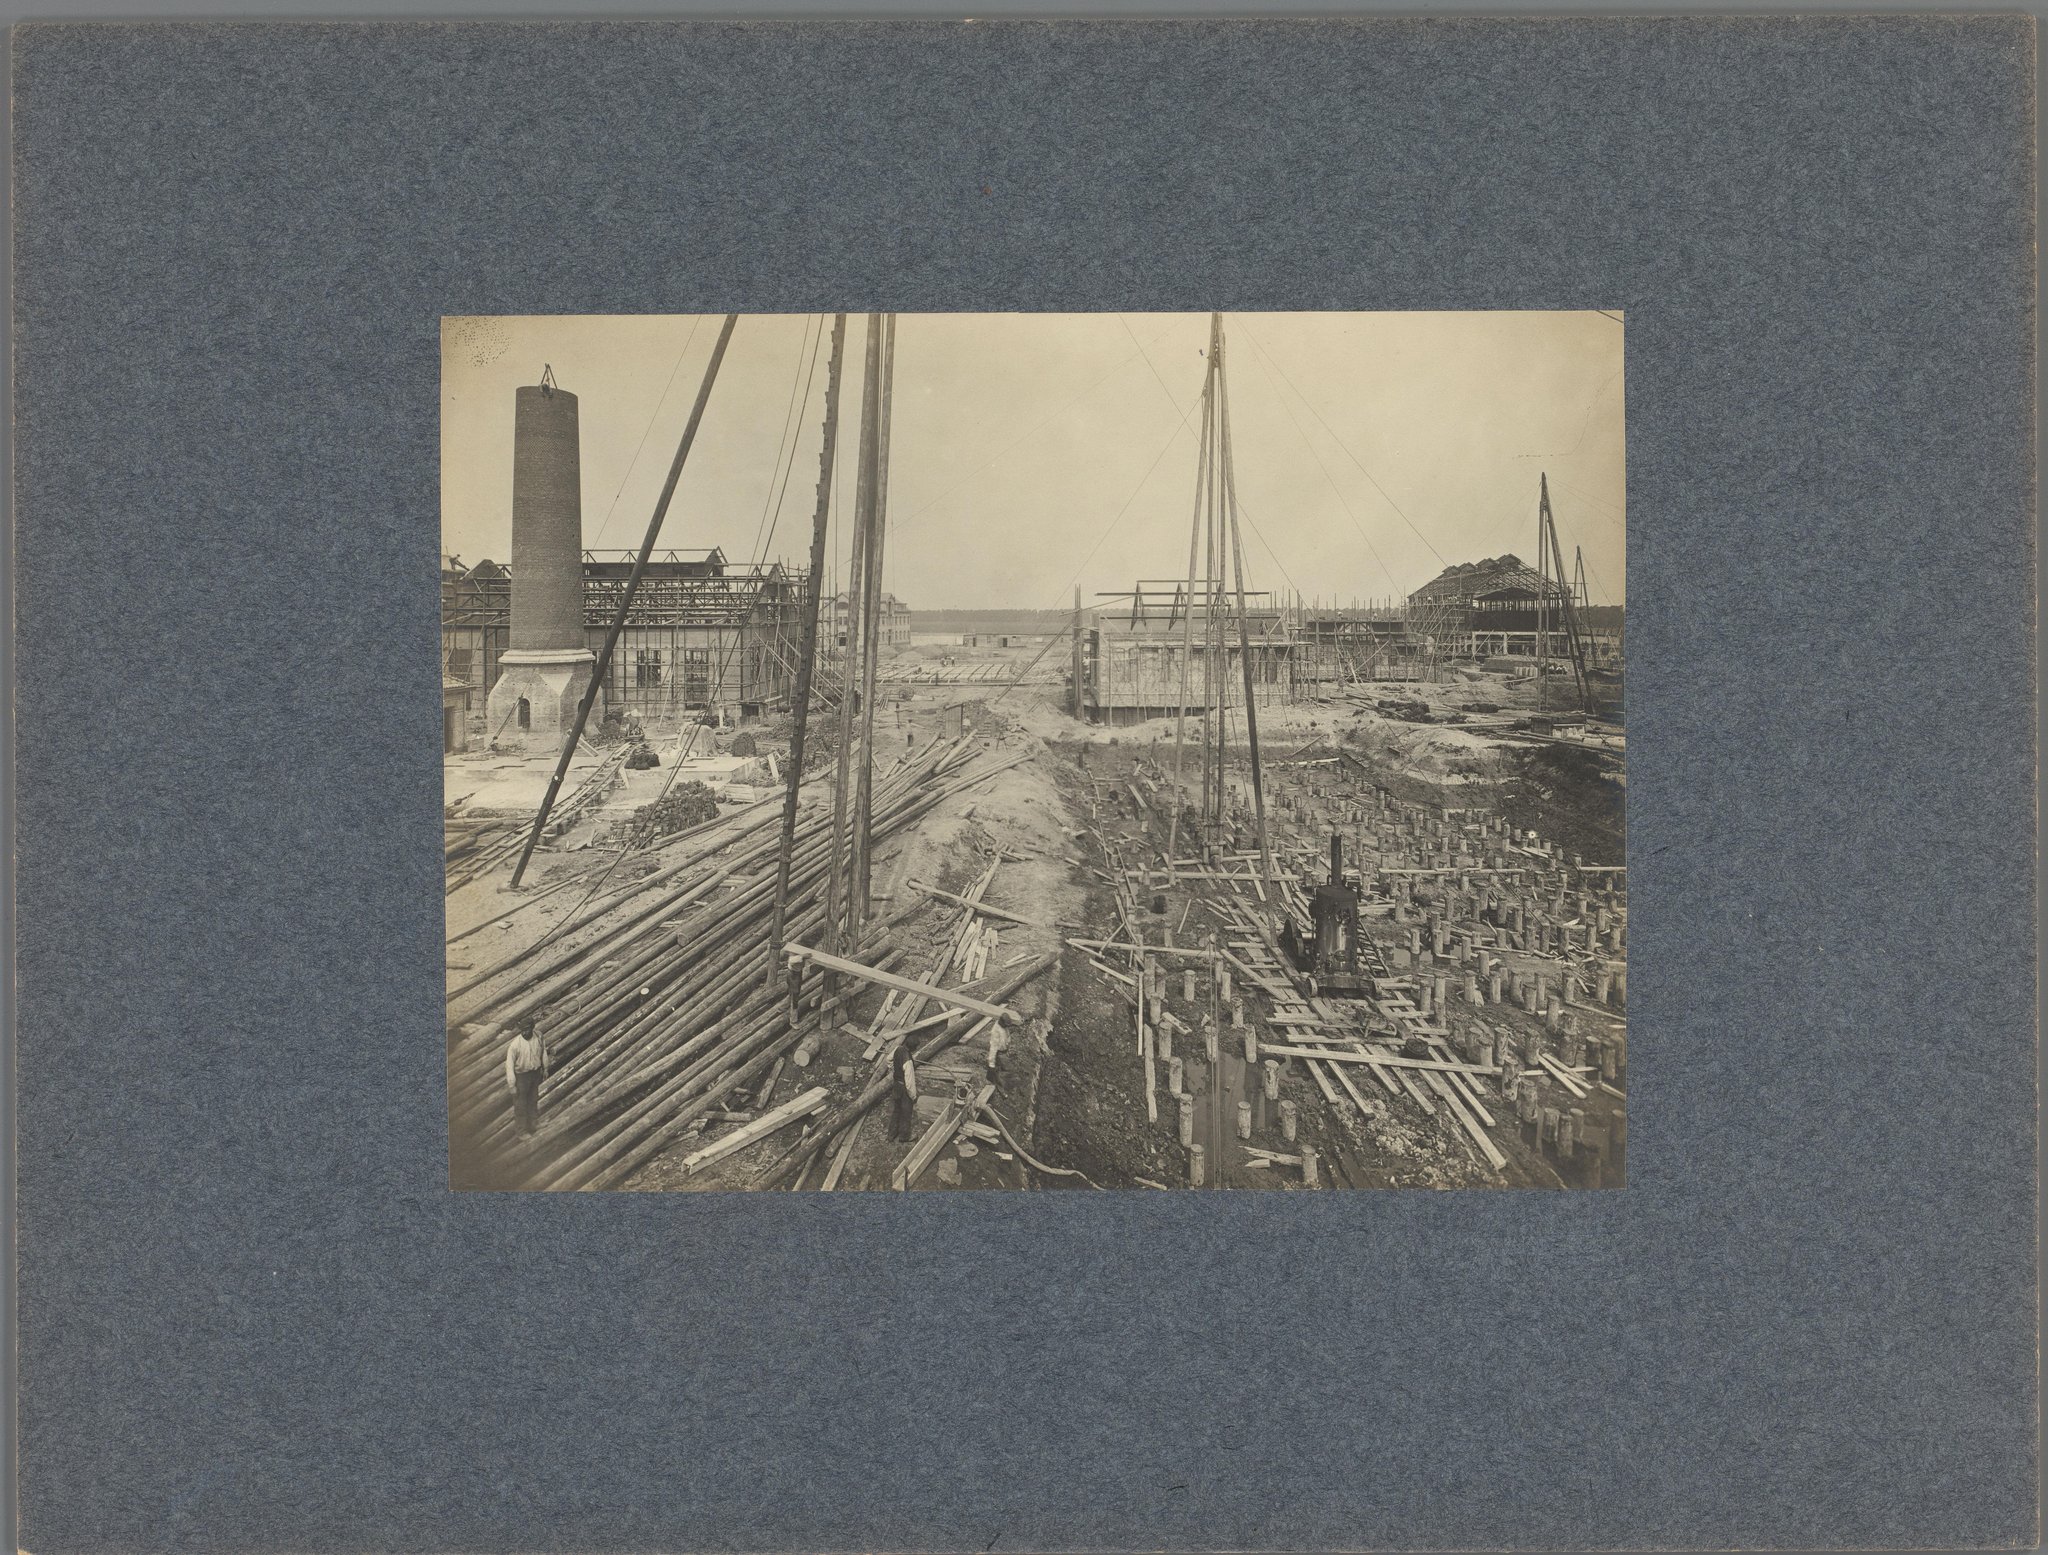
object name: photograph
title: Bouw van de grote gashouder van de gasfabriek in de Keilehaven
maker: willem sr. bleuzé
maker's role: fotograaf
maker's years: 1873-1948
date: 1912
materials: paper, cardboard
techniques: gelatin silver print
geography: rotterdam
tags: large-scale structure for storage, e.g.: warehouse, depot, silo, gasworks, building-site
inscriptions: address: ‘W. BLEUZÉ/ ROTTERDAM/ JONKER FRANSSTRAAT 66’, inscription: ‘25 juli 1912’